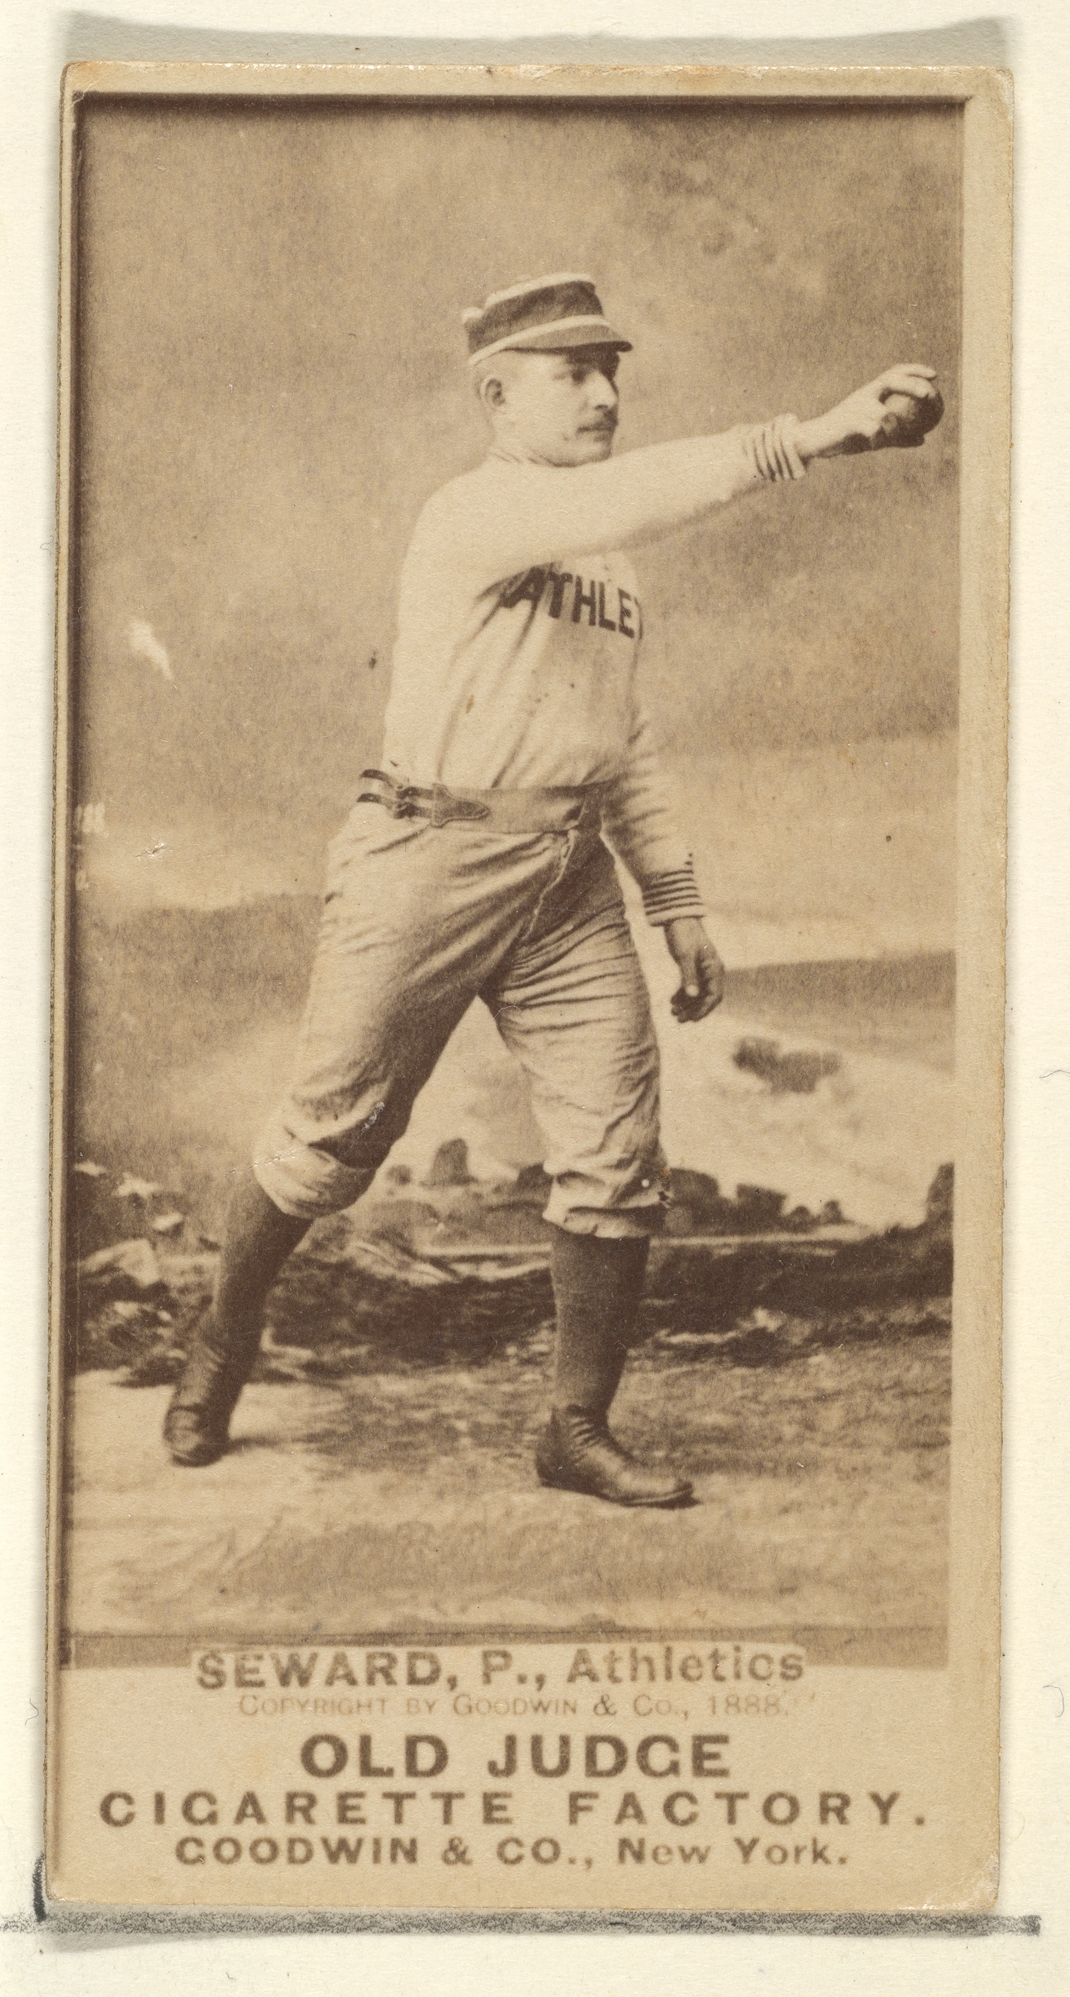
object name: baseball card, photograph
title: Seward, Pitcher, Philadelphia Athletics, from the Old Judge series (N172) for Old Judge Cigarettes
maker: goodwin & company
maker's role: publisher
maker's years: 1850-1950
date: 1888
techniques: albumen silver print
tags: men,portraits,baseball,athletes